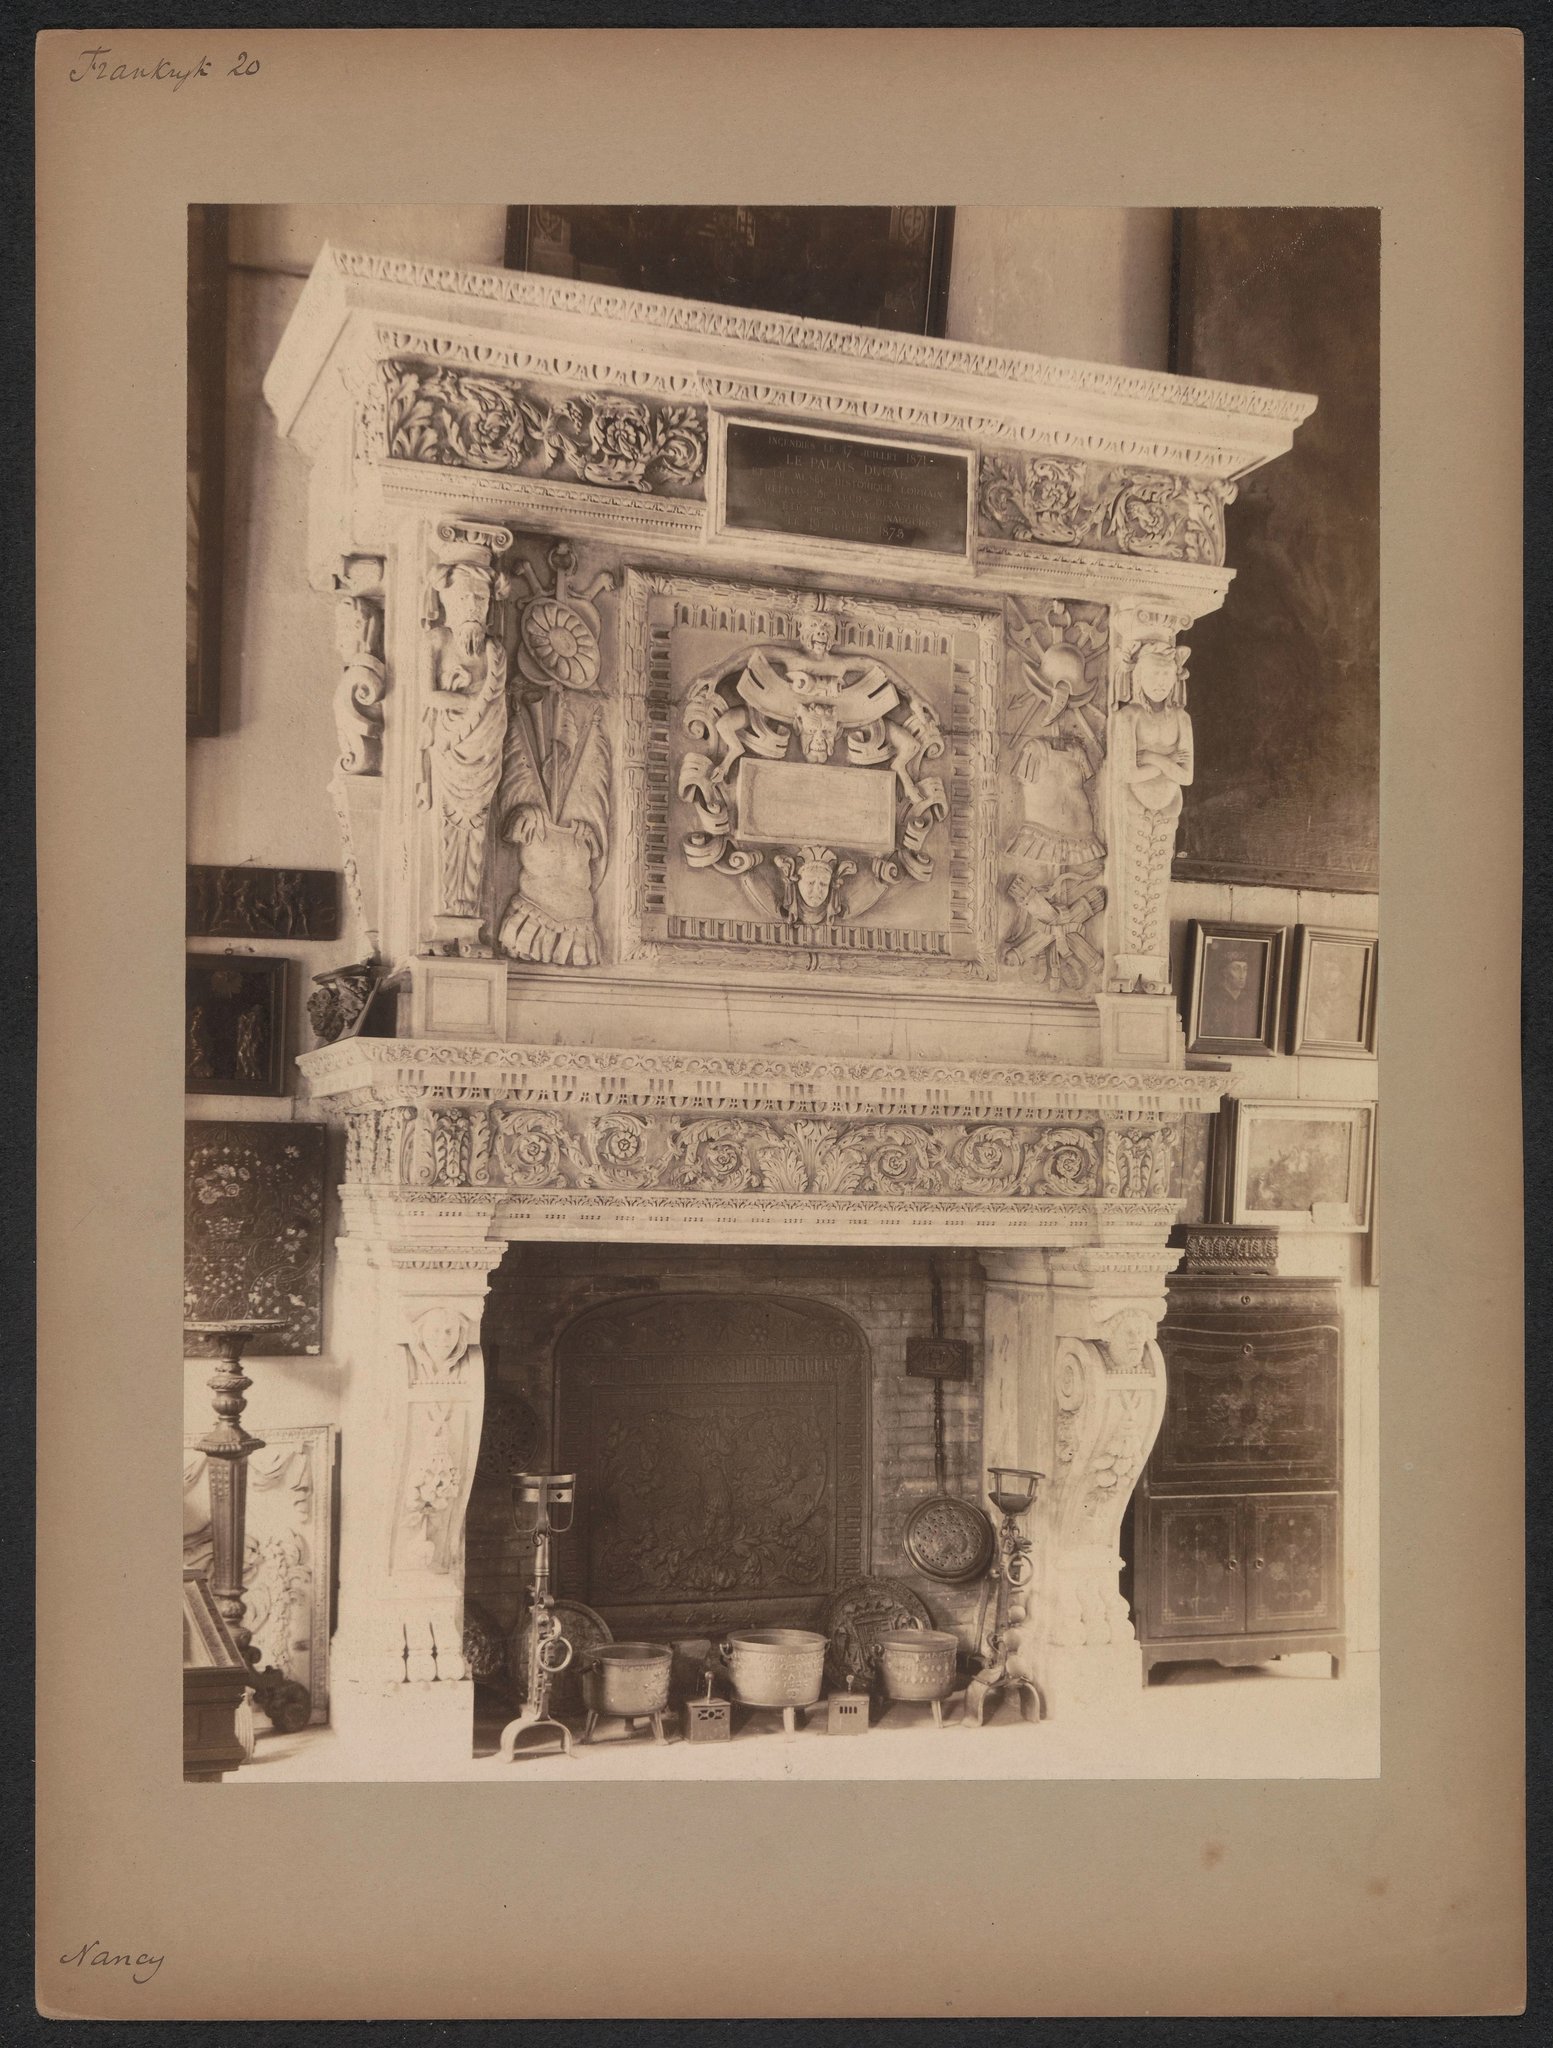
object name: photograph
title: Gedecoreerde schoorsteenmantel, vermoedelijk in het Palais Ducal in Nancy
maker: Anonymous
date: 1850-1900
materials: cardboard, photographic support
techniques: albumen print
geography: nancy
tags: chimney-piece, mantelpiece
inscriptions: annotation: ‘Nancy/ Chéminée/ Palais ducal’, collector's mark: ‘RIJKS NORMAALSCHOOL voor T[EEKENONDERWIJZERS] AMSTERDAM’, annotation: ‘Nancy’, annotation: ‘Frankrijk 20’